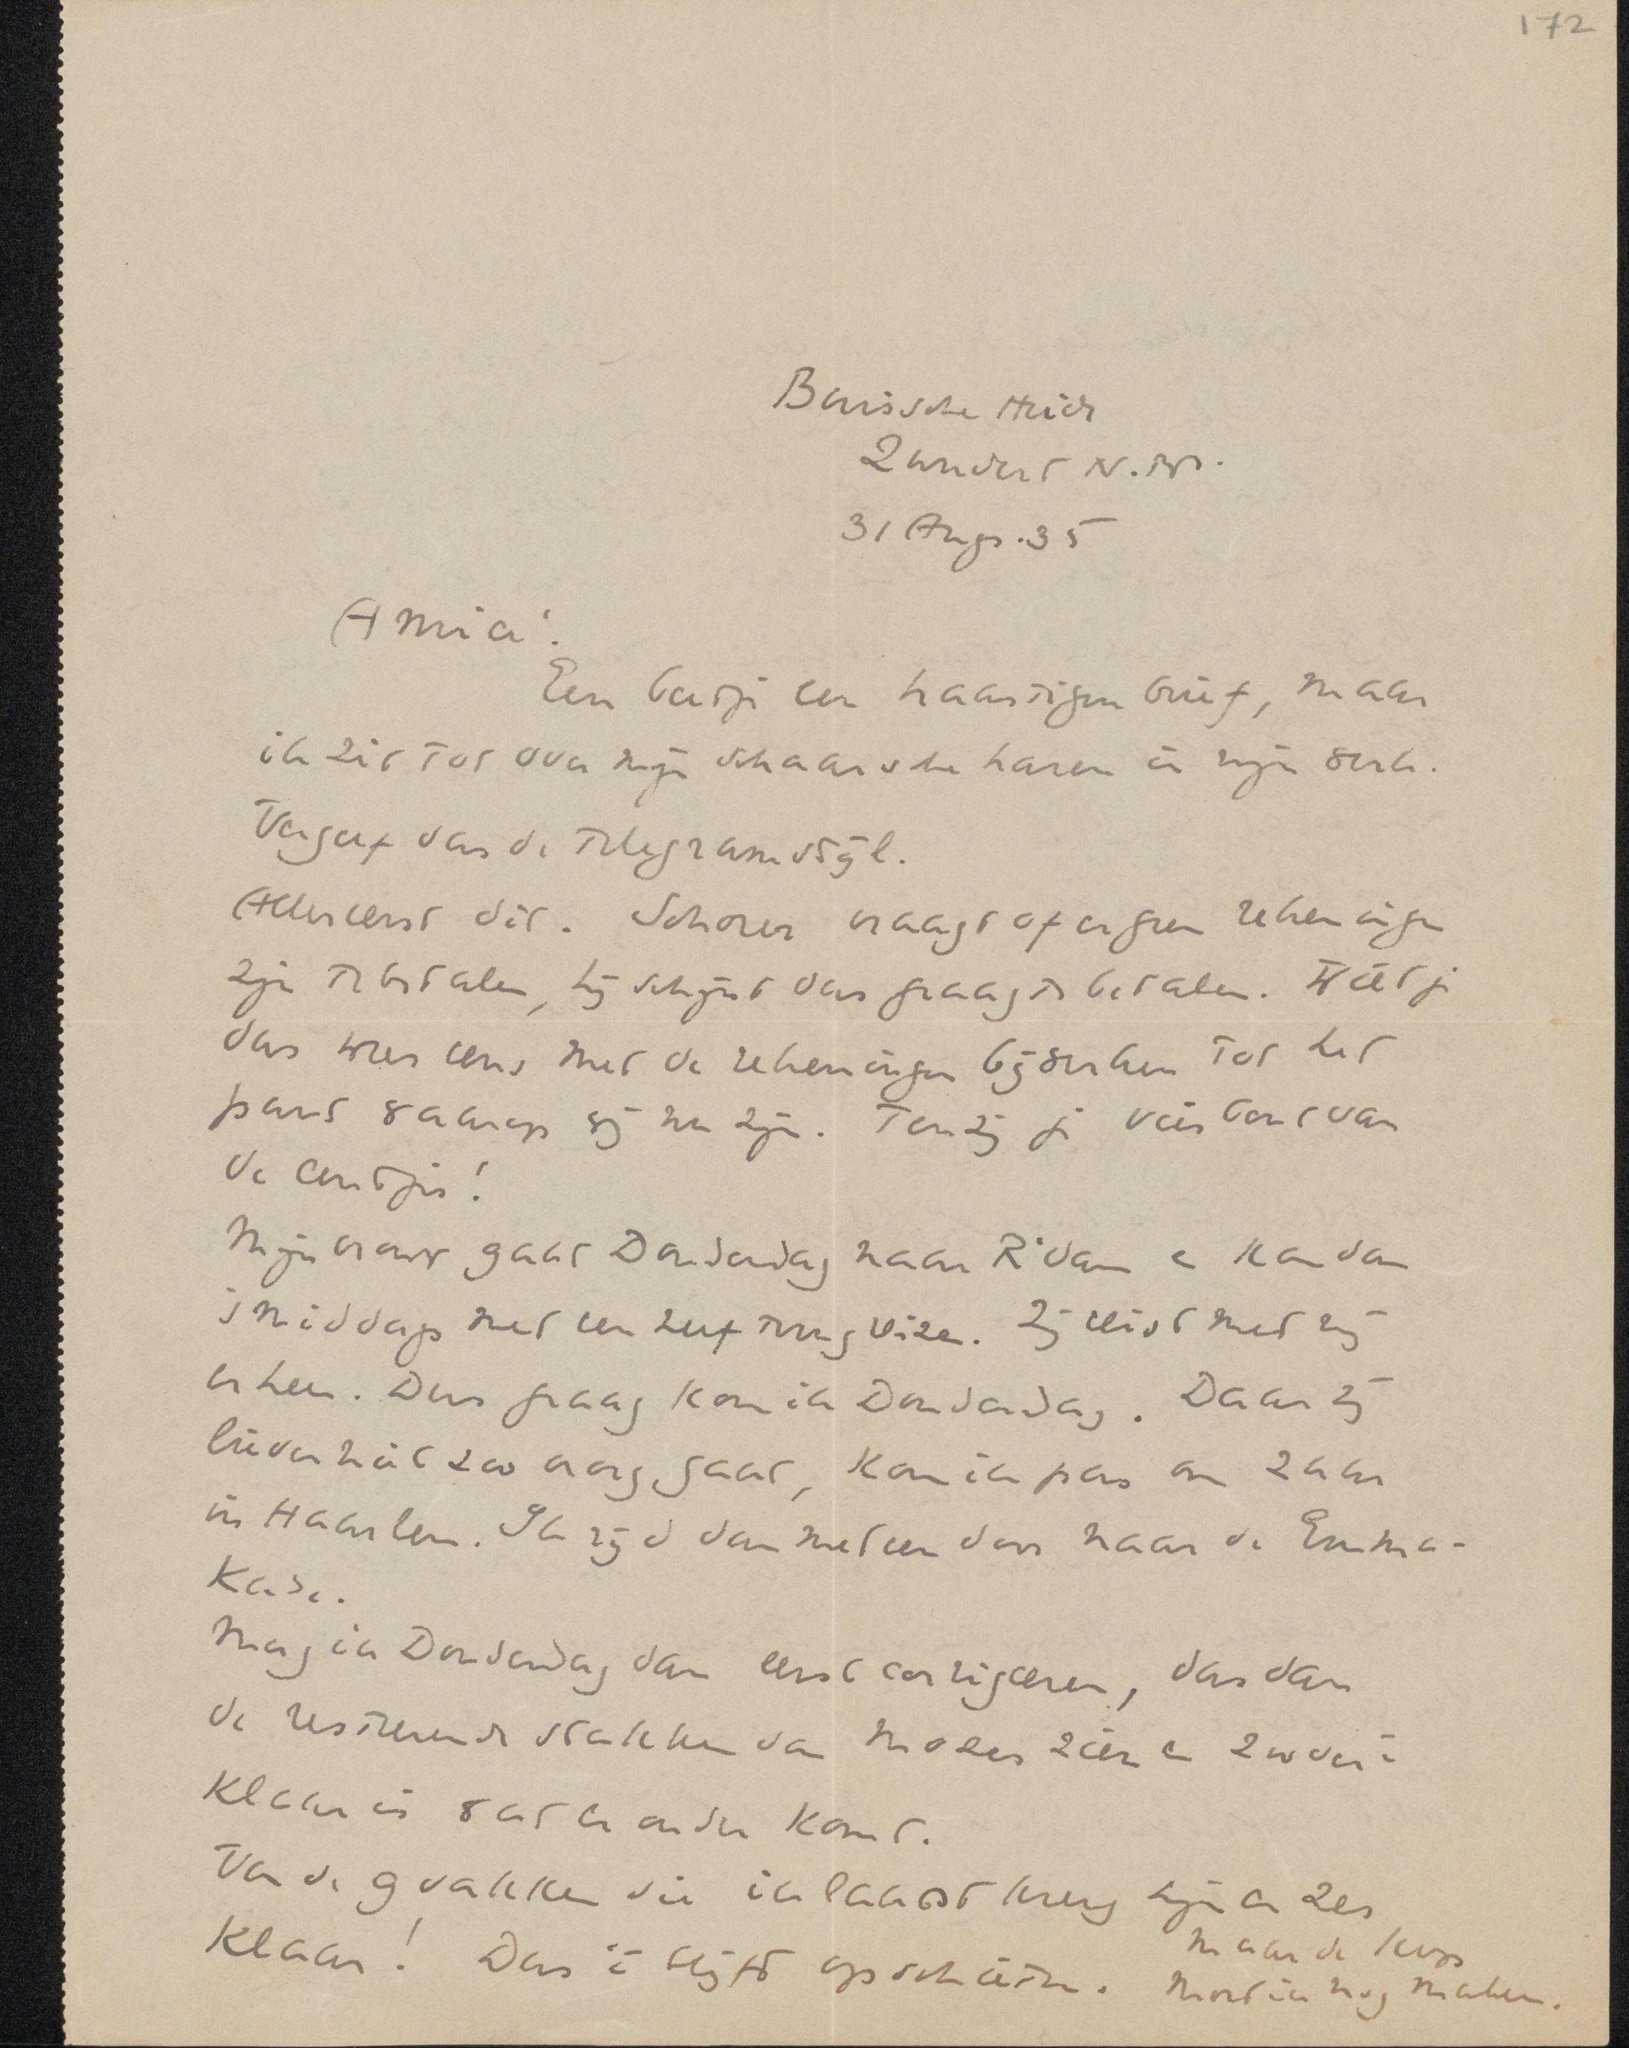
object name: letter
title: Brief aan Willem Bogtman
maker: richard nicolaüs roland holst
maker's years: 1868-1938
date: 1935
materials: ink, paper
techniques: pen, writing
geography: buissche heide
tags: utrecht, haarlem, willem bogtman, applied arts, arts and crafts; industrial design, photography, cinematography, money